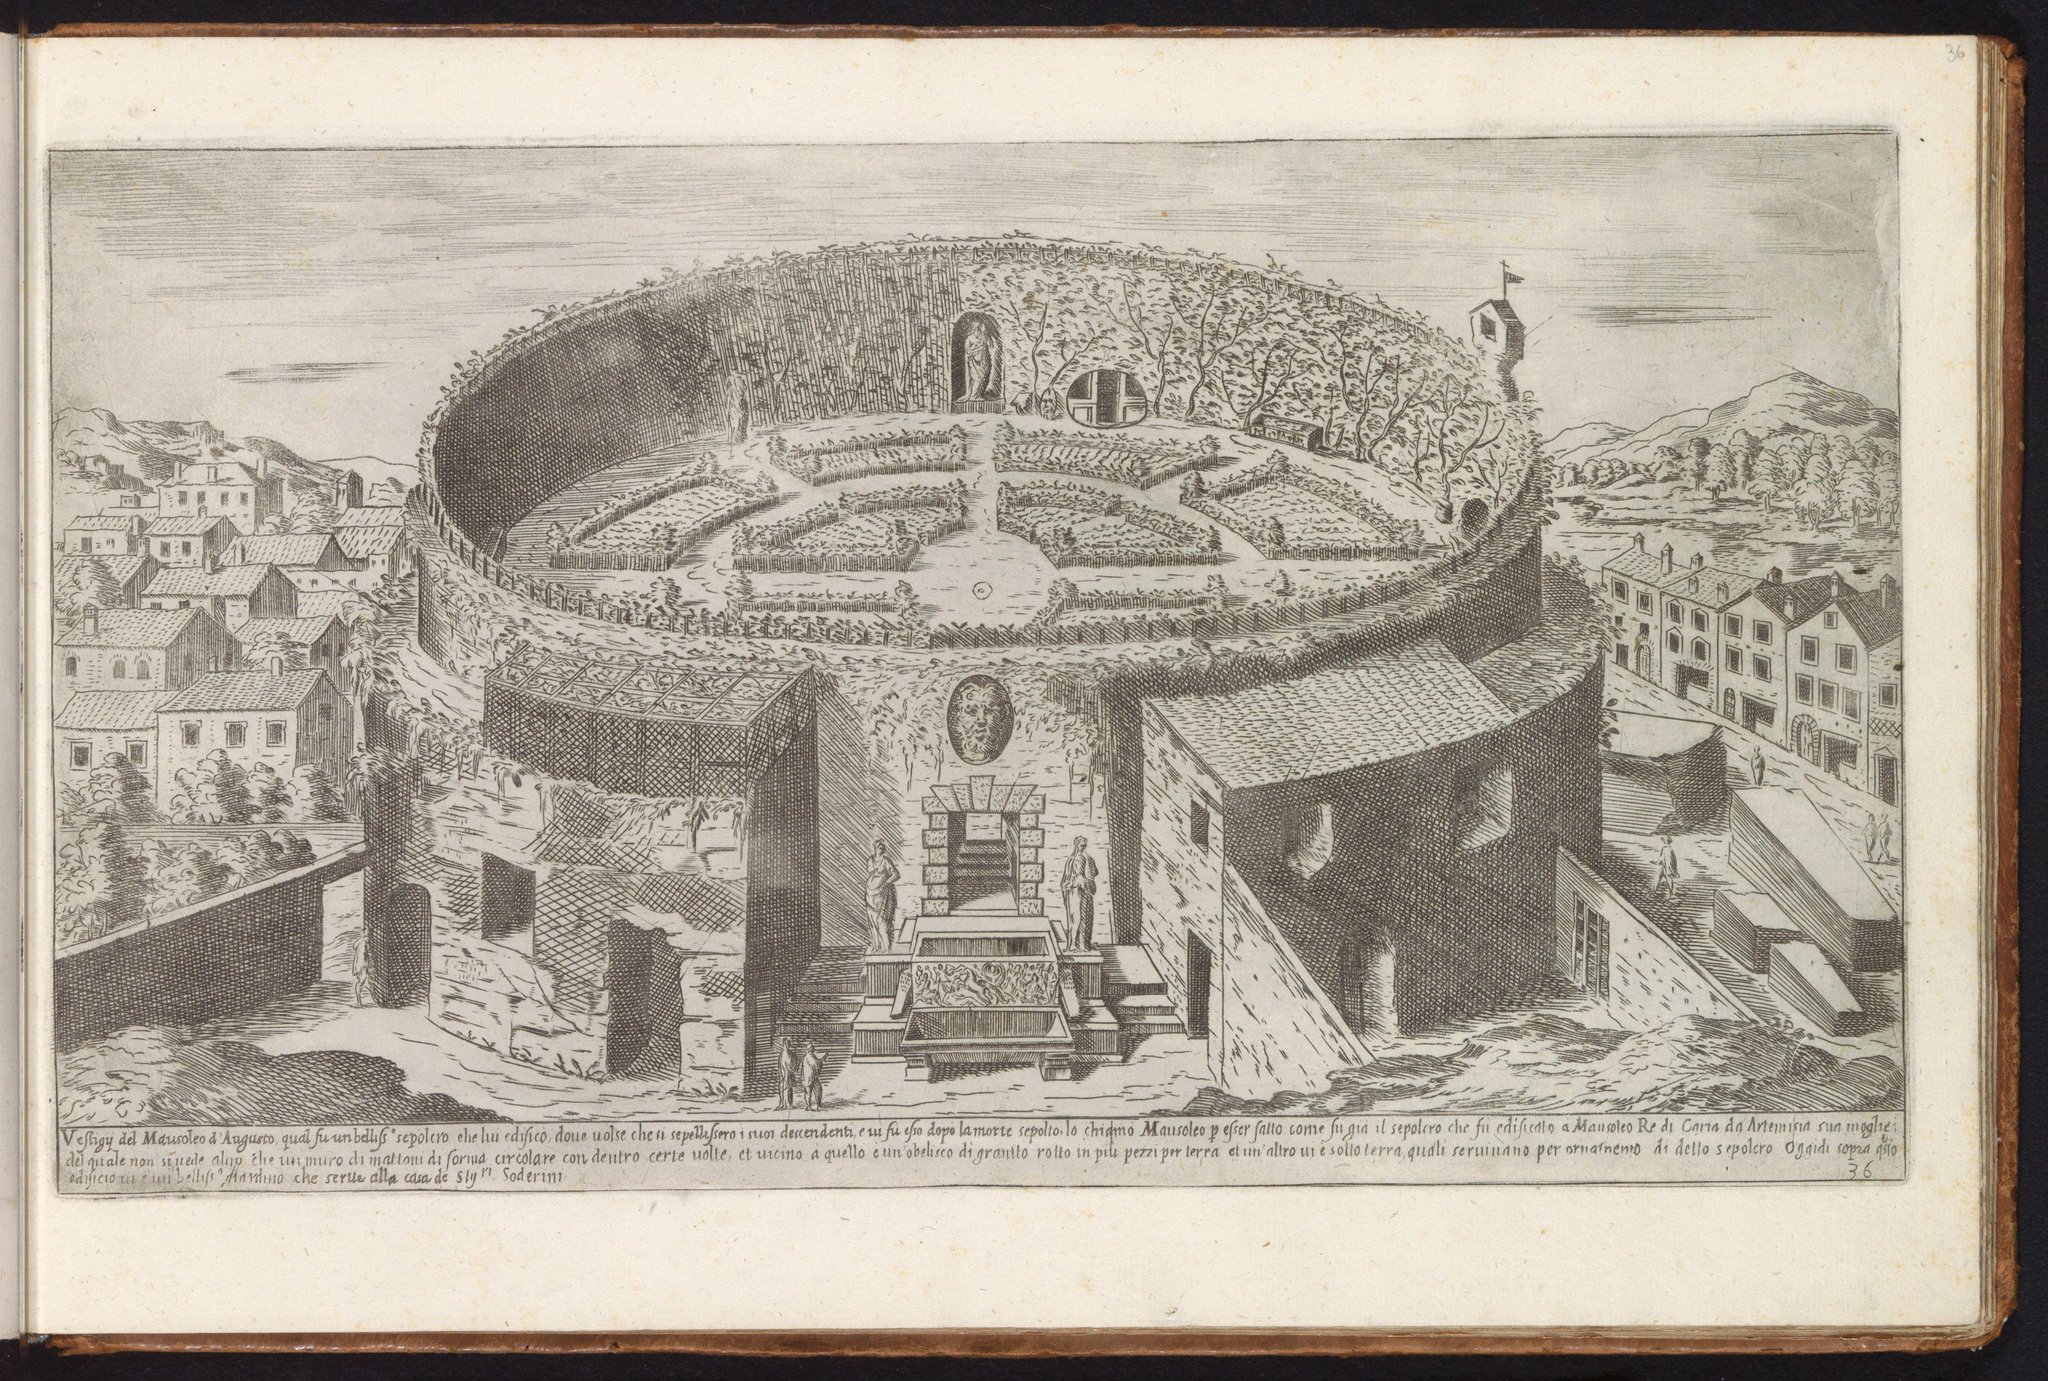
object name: album leaf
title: Bouwwerken uit de oudheid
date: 1575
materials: paper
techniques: engraving, etching, intaglio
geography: rome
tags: city-view, and landscape with man-made constructions, ruin of a building ~ architecture, garden, landscape with ruins, mausoleum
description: Gezicht op het Mausoleum van Augustus met een aangelegde tuin te Rome. Onderschrift in het Italiaans. Prent maakt deel uit van een album.